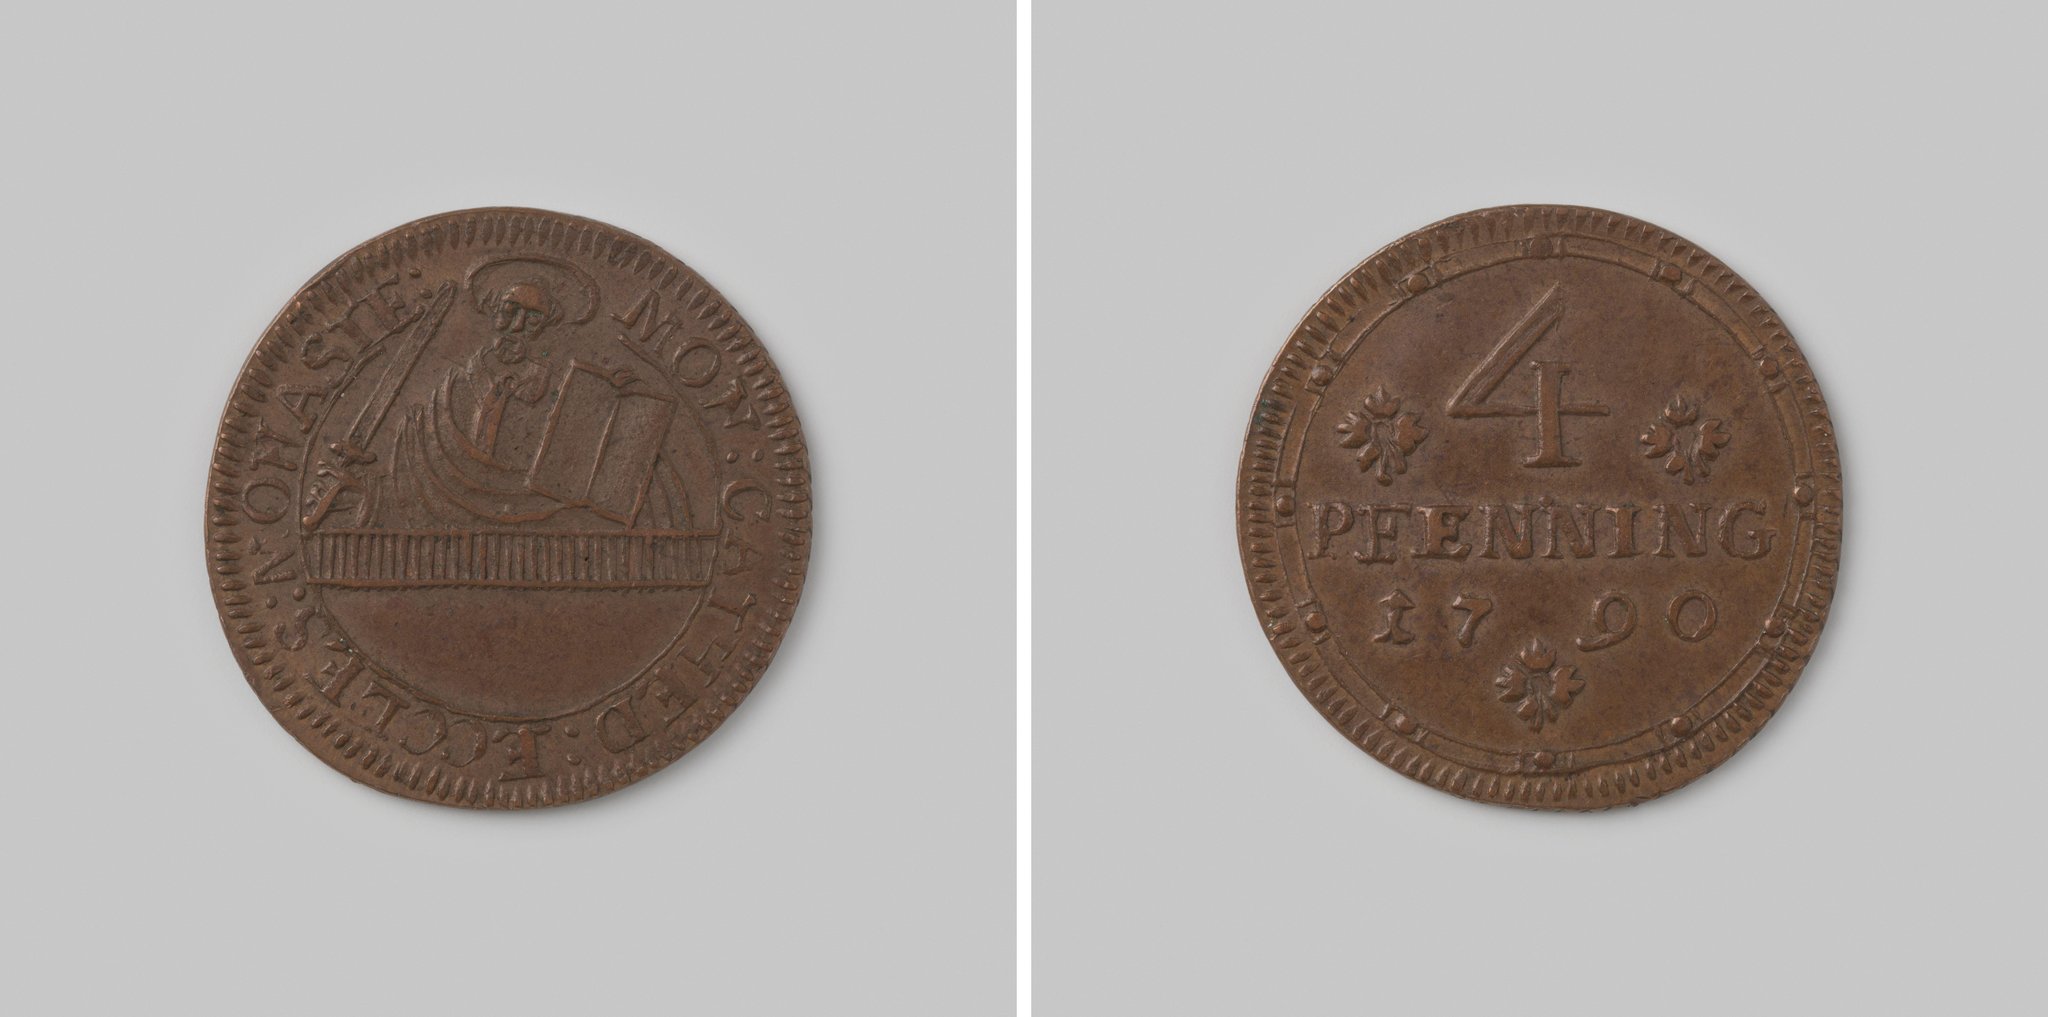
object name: vier pfenning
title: Vier pfenning uit het domkapittel van Münster, 1790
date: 1790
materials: copper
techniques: striking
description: Koperen munt. Voorzijde: de heilige Paulus met boek en zwaard, zittend aan een tafel. Keerzijde: binnen een cirkelvomige versiering waarde-aanduiding in twee regels, waaronder jaartal. Kabelrand.